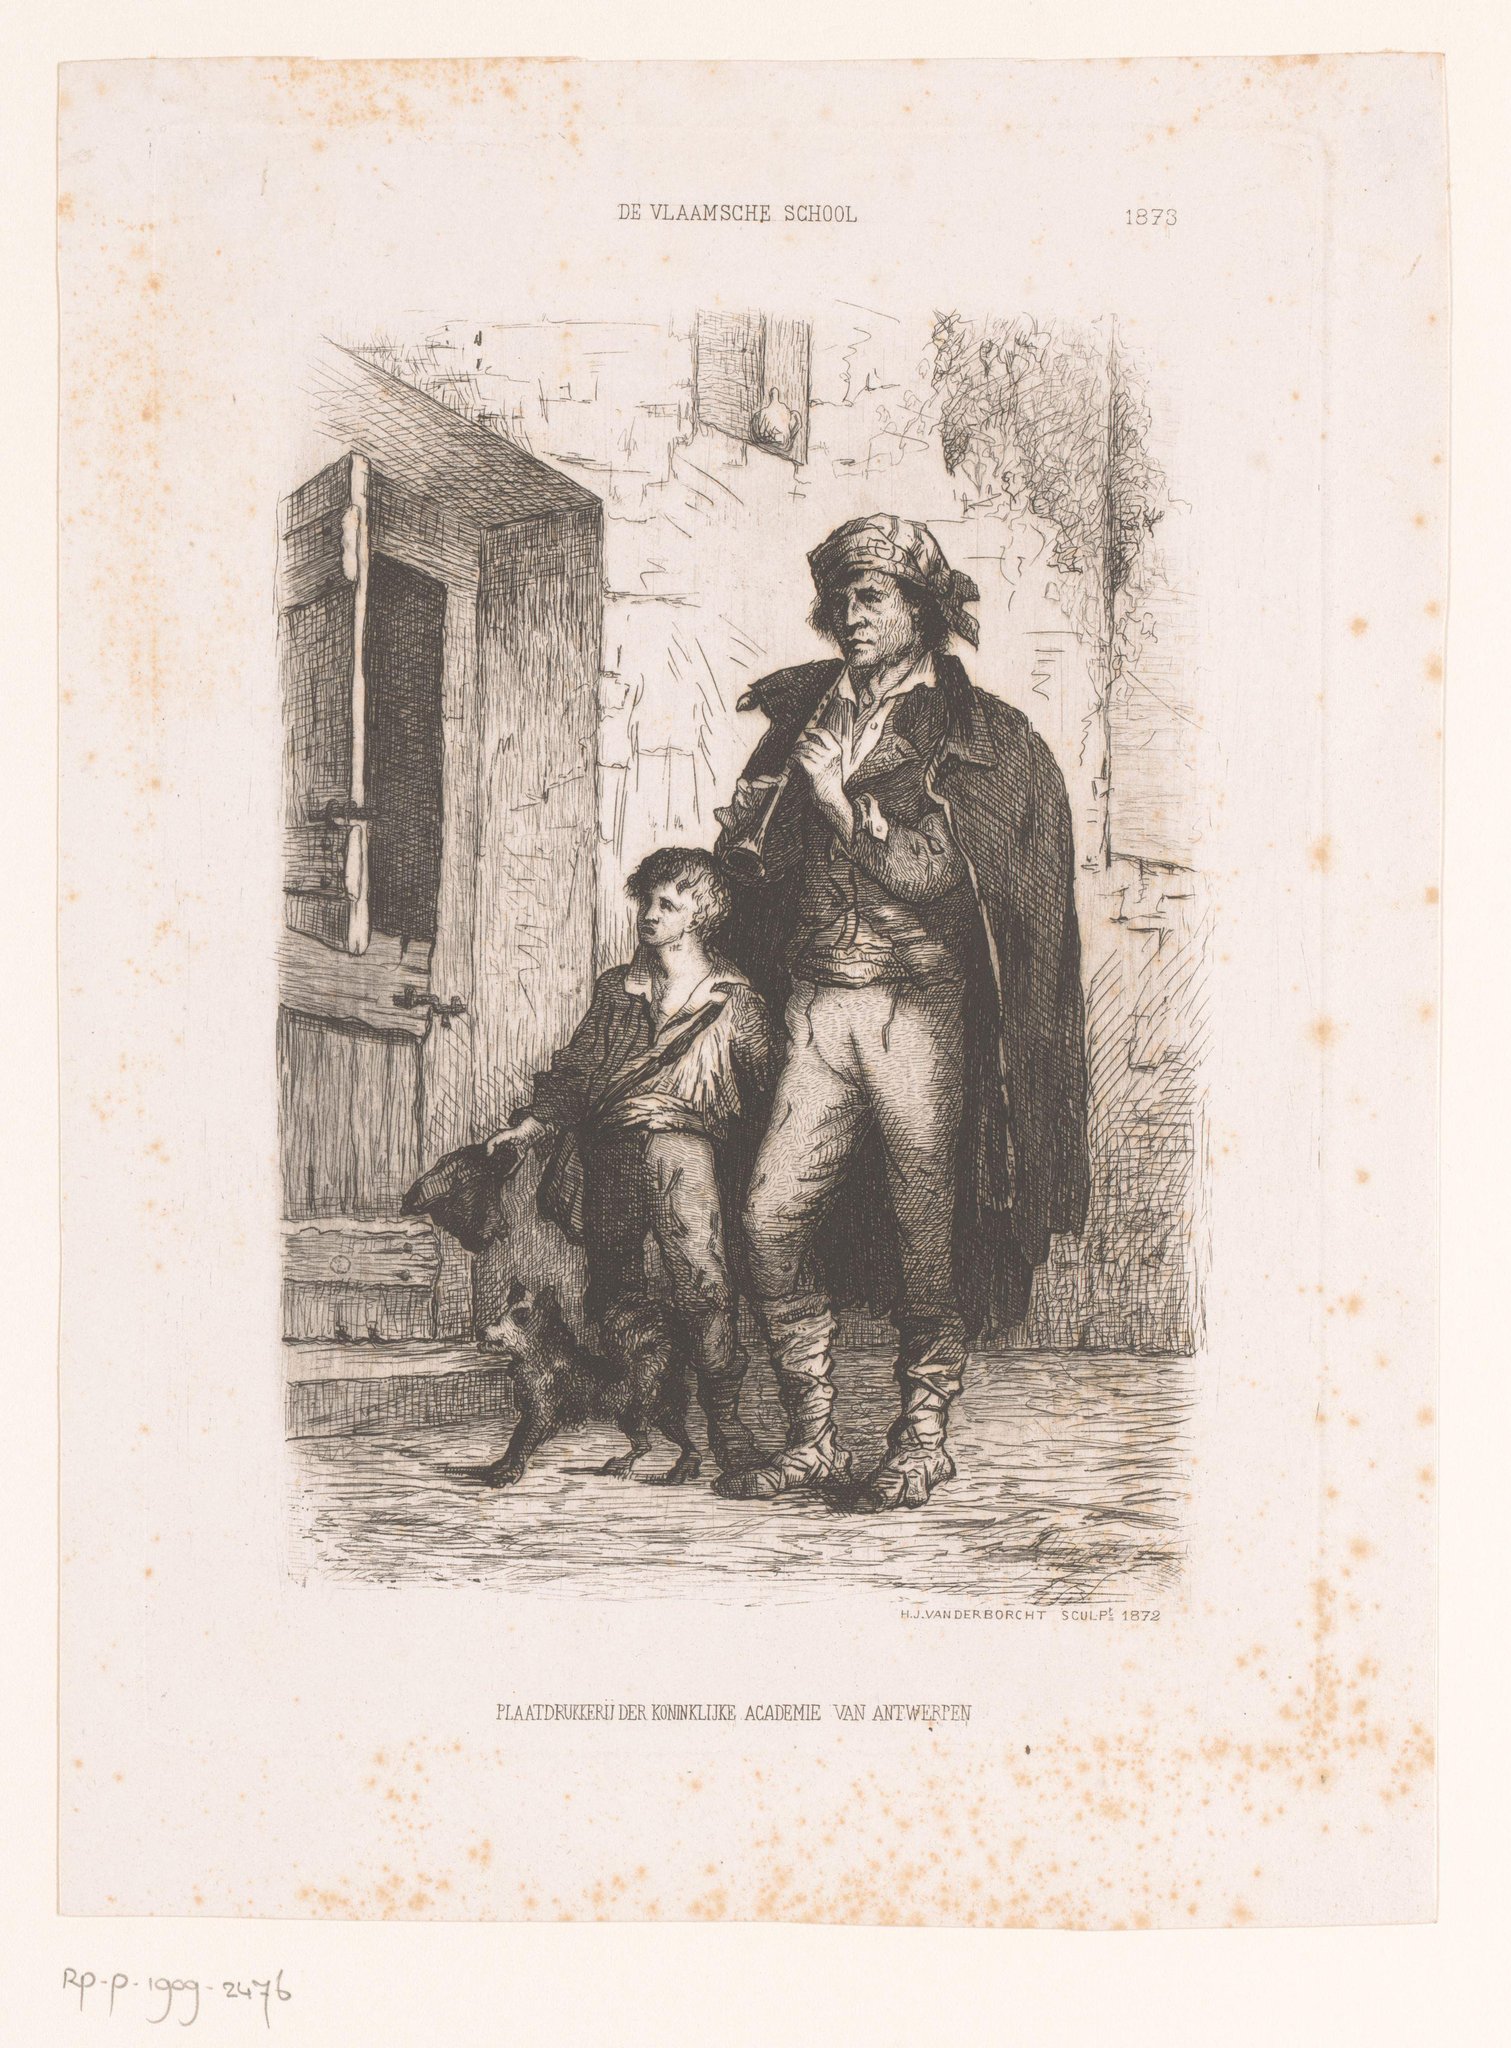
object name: print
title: Straatmuzikant en een bedelende jongen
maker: hendrik j. van der borcht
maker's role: print maker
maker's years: 1849-1918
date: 1872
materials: paper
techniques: etching, intaglio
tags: popular music, street music - cc - out of doors, beggar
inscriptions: collector's mark: Lugt 2228